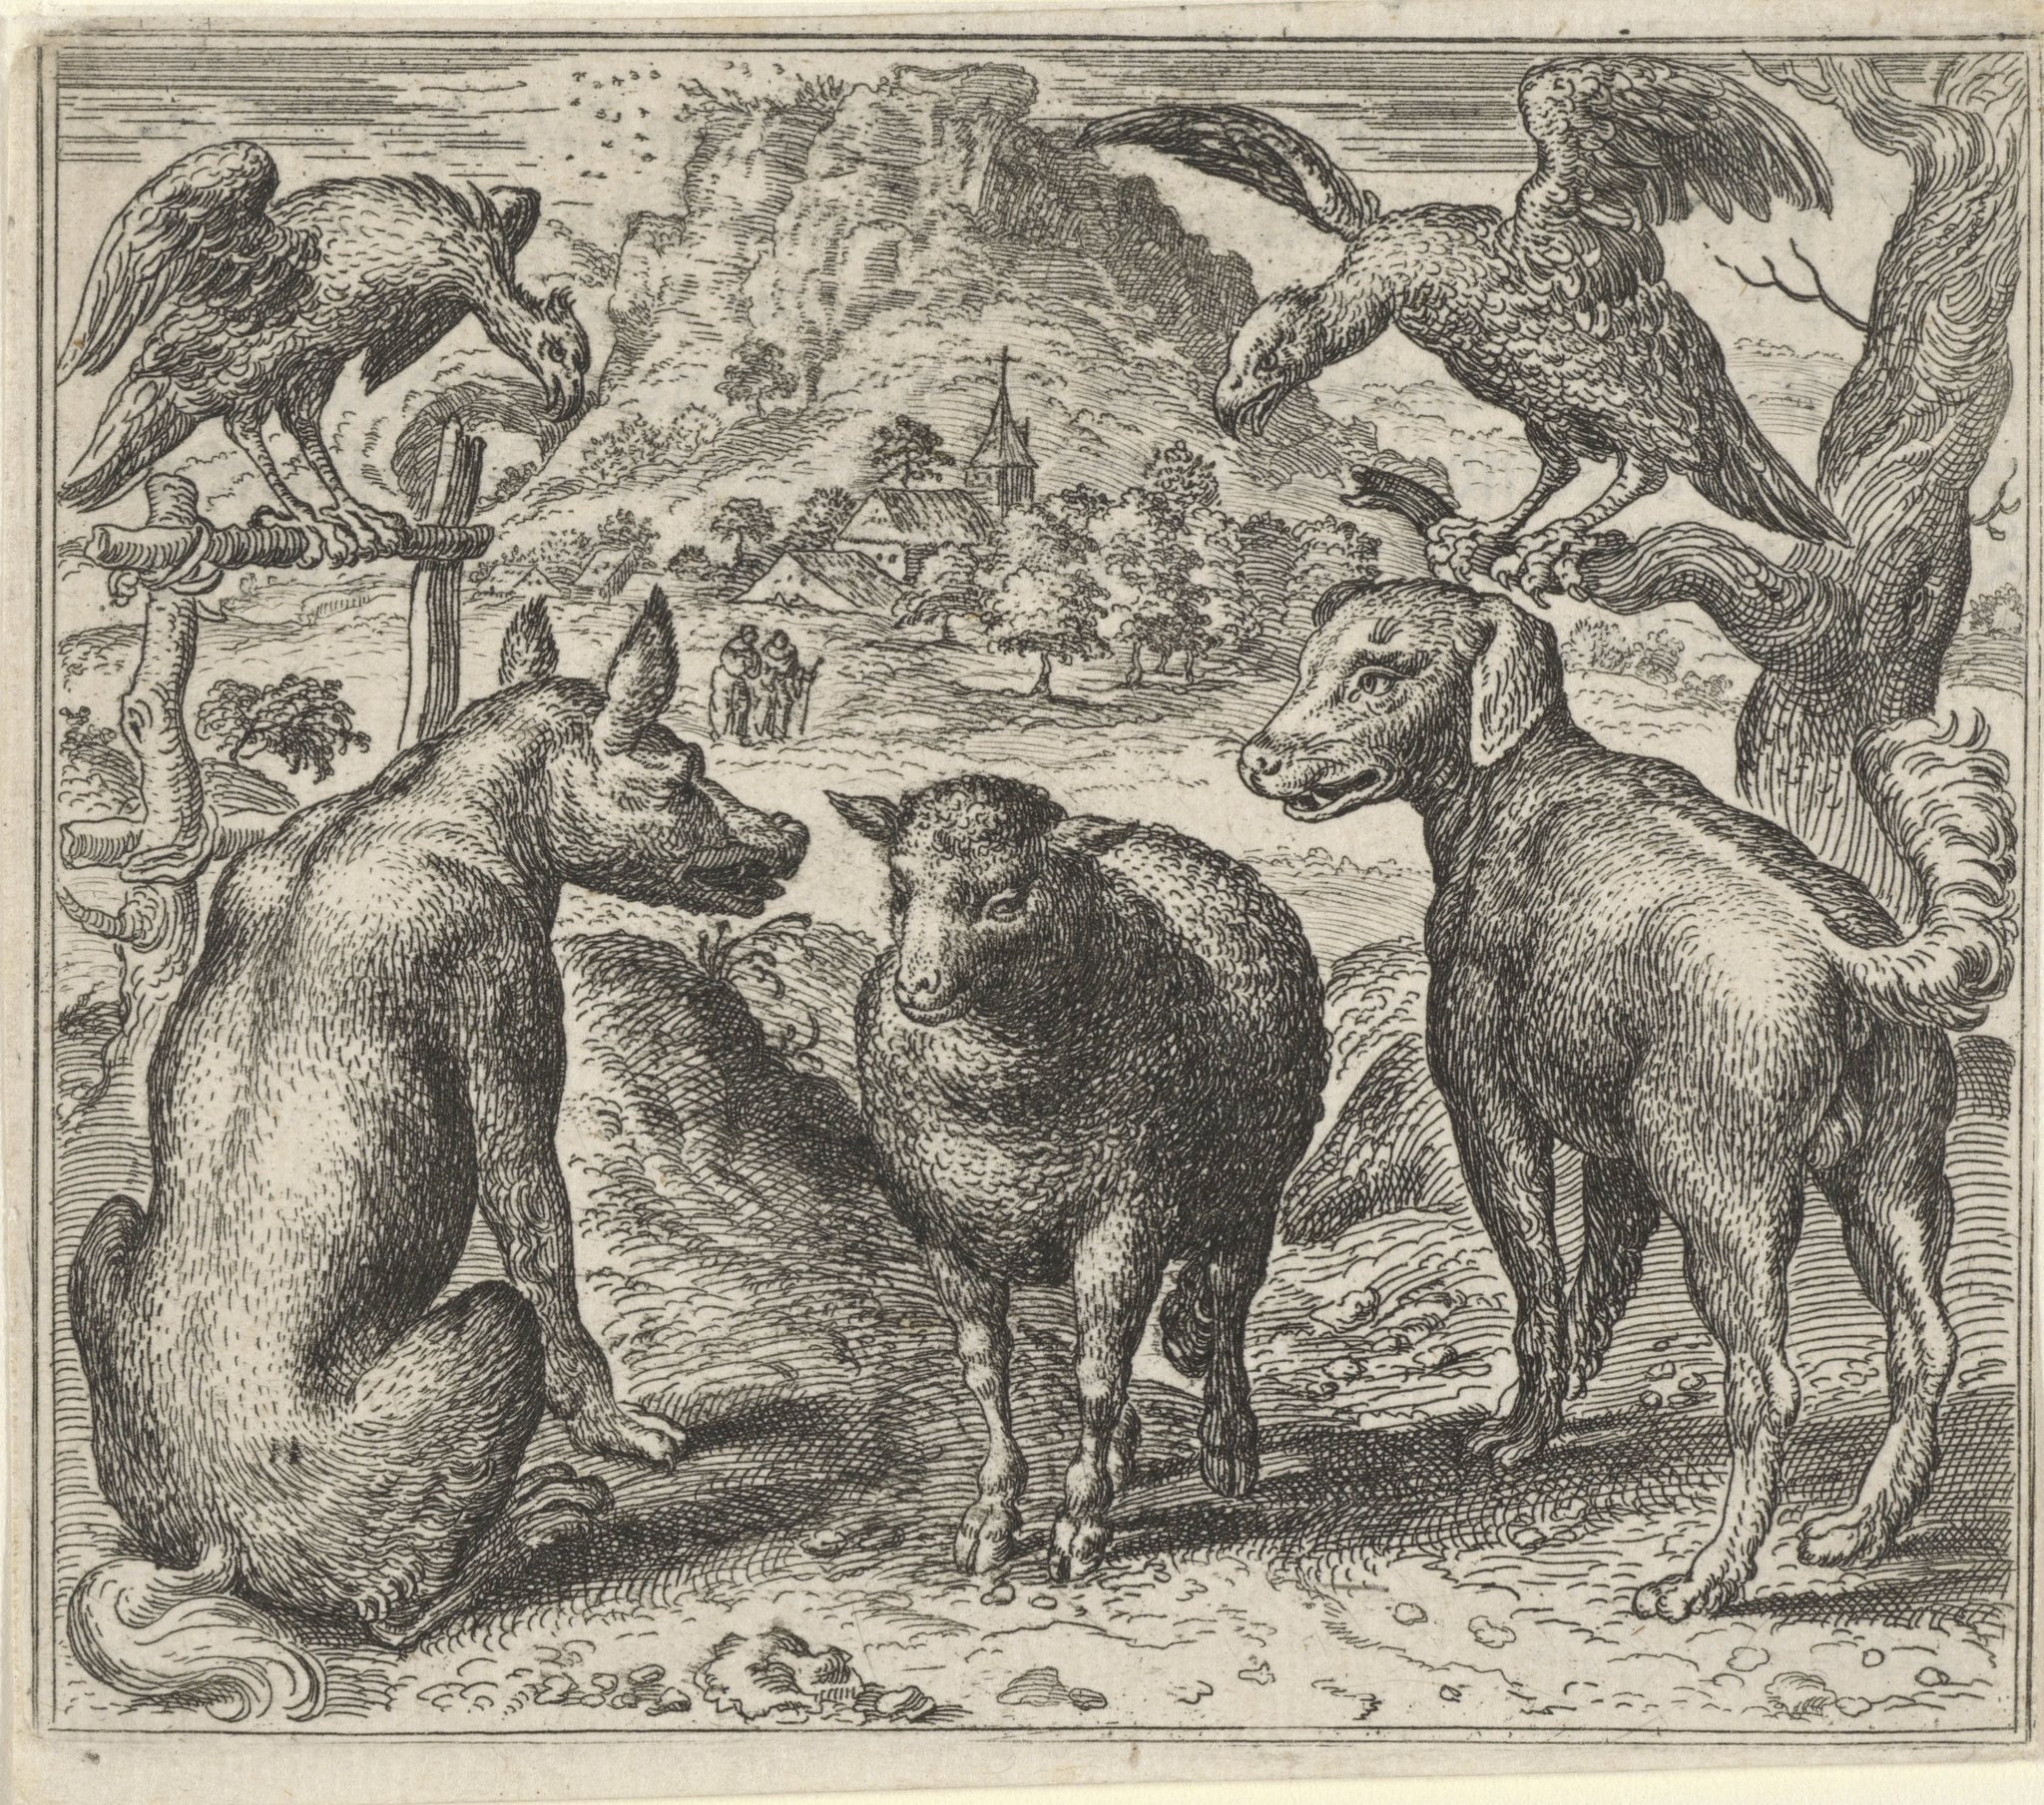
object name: print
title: Fabel van de wolf en zijn rechtszaak tegen het schaap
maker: aegidius sadeler (ii)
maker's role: draughtsman, print maker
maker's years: 1568-1629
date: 1608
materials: paper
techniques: engraving, etching, letterpress printing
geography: prague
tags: court session (court of justice) (+ abuse of legal power), sheep, predatory birds: vulture, fables, dog, beasts of prey, predatory animals: wolf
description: De wolf heeft een rechtszaak aangespannen tegen het schaap. Rondom hem zijn getuigen: twee gieren en een hond. De fabel waarschuwt voor machtsmisbruik in het rechtssysteem.